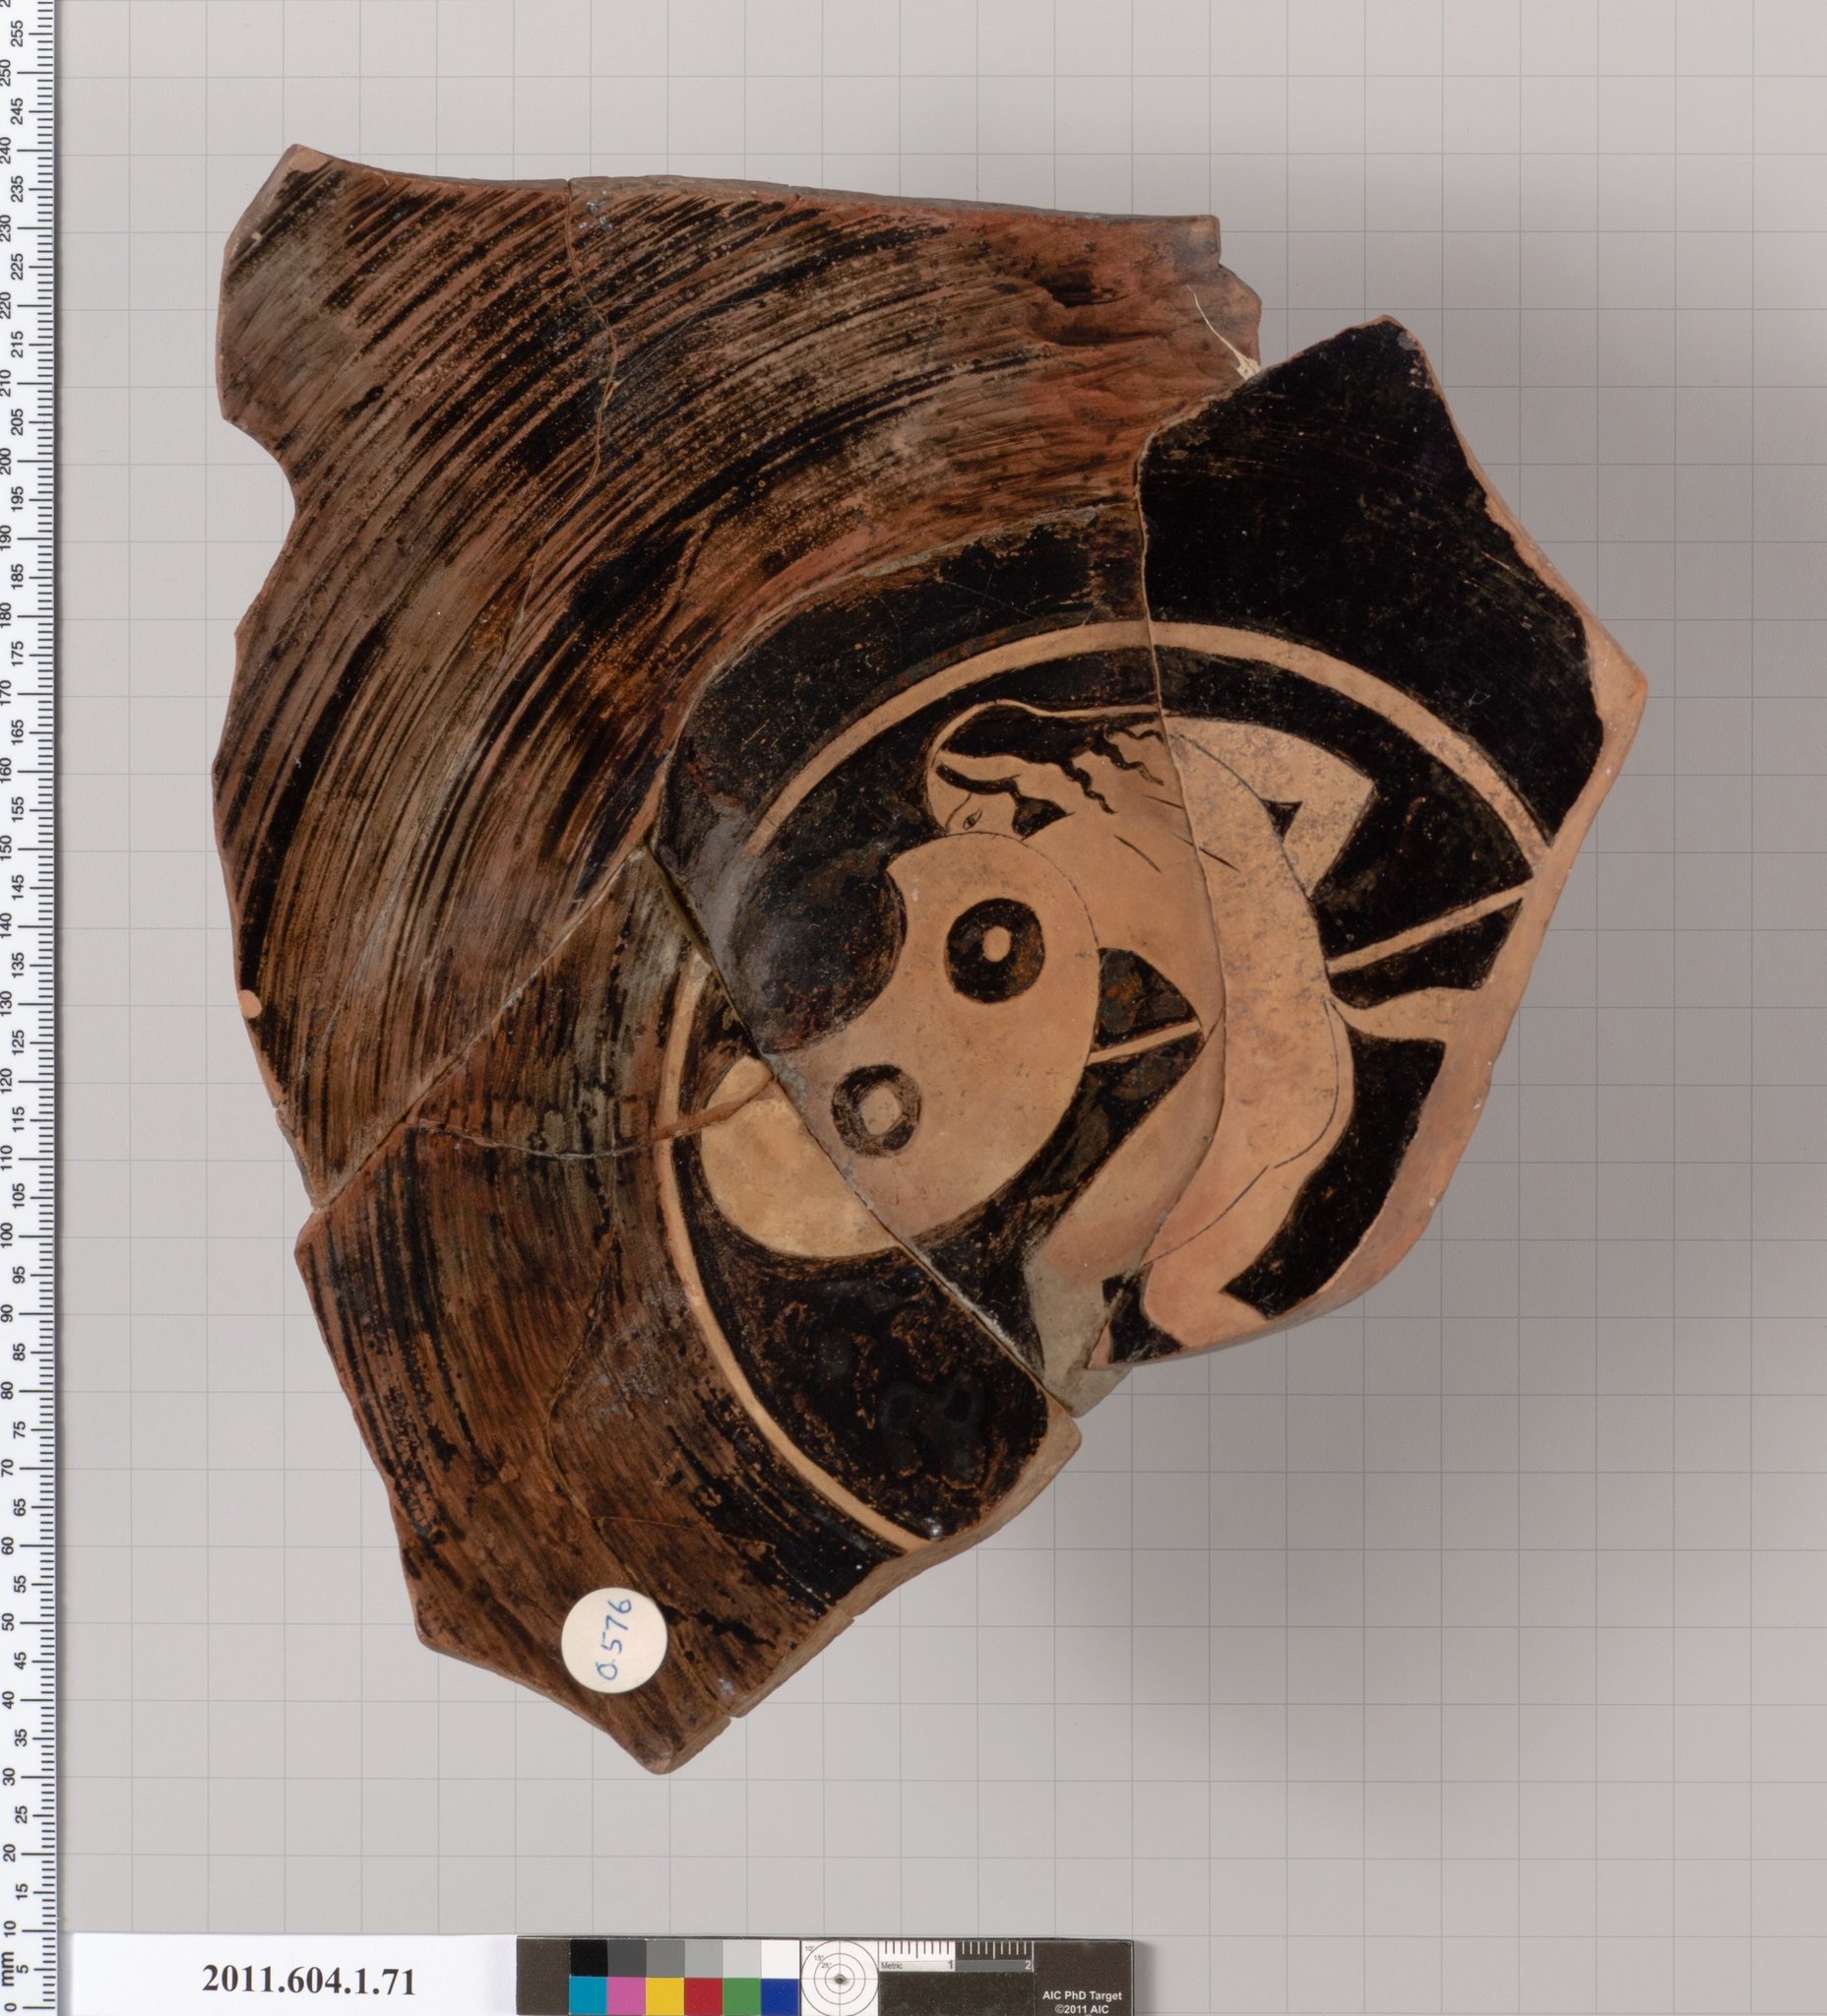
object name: kylix fragment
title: Terracotta fragment of a kylix (drinking cup)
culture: greek, attic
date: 520-500 BCE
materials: terracotta